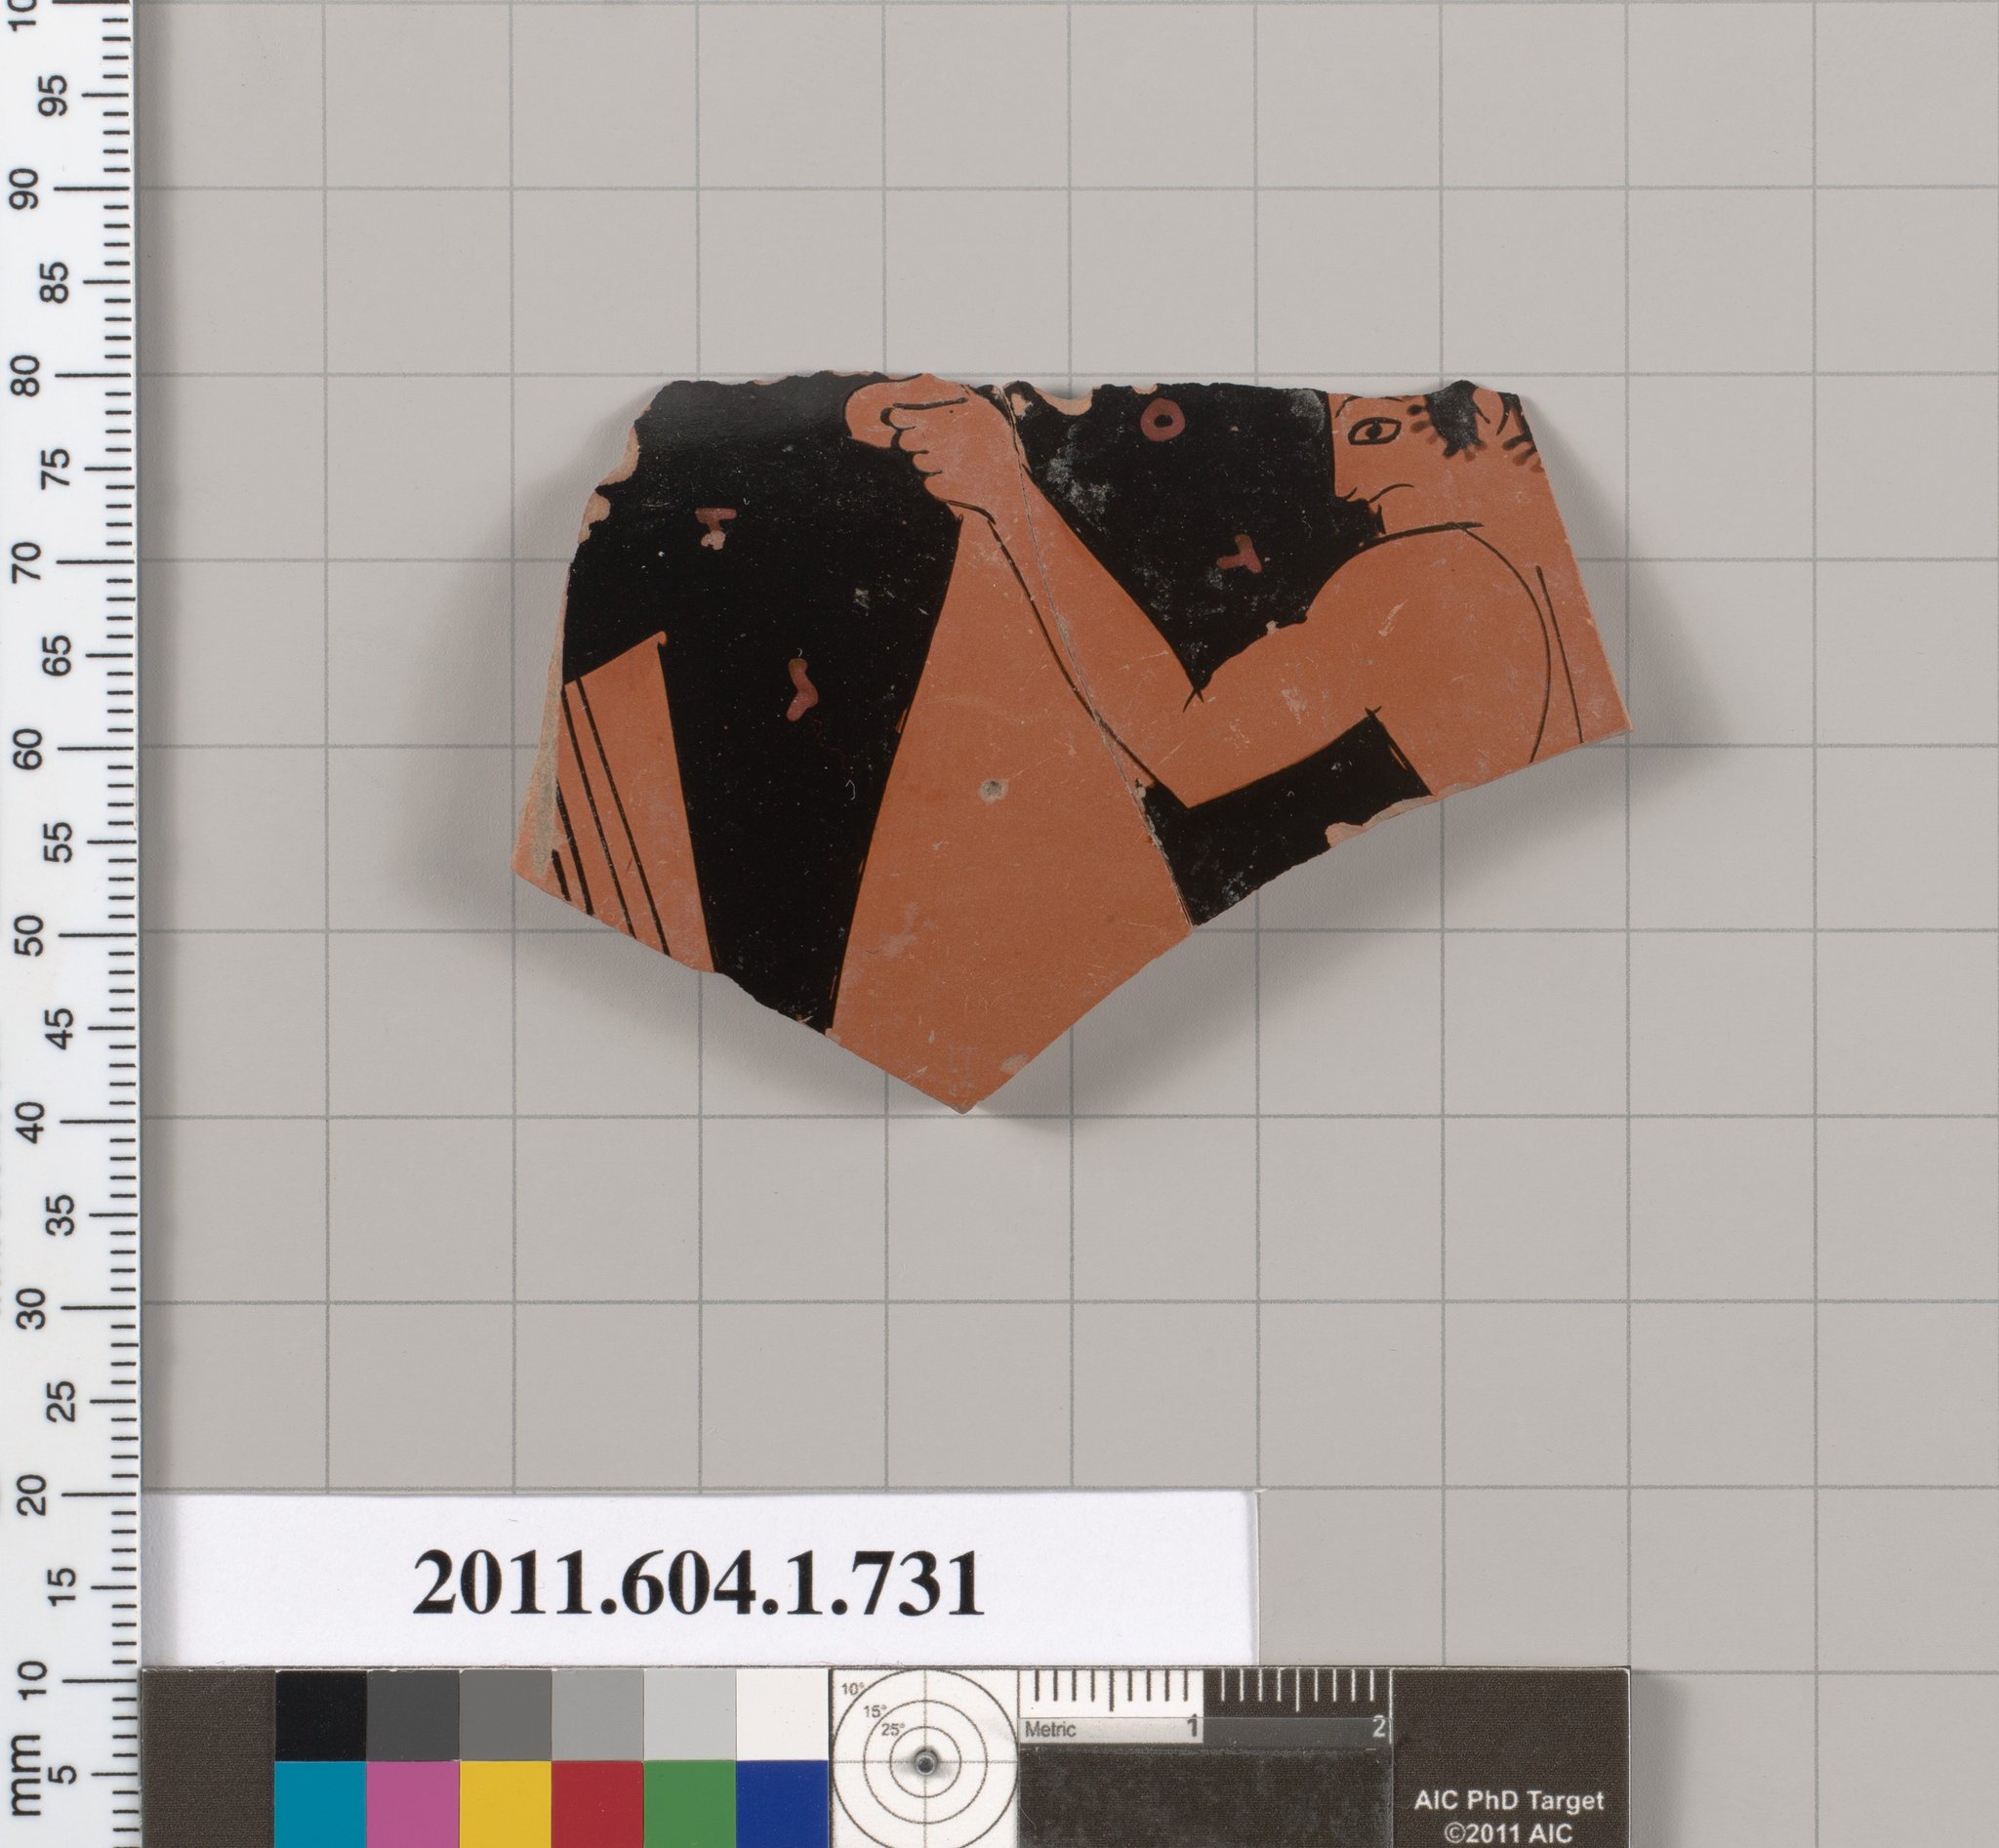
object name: kylix fragment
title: Terracotta fragment of a kylix (drinking cup)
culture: greek, attic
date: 534-501 BCE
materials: terracotta